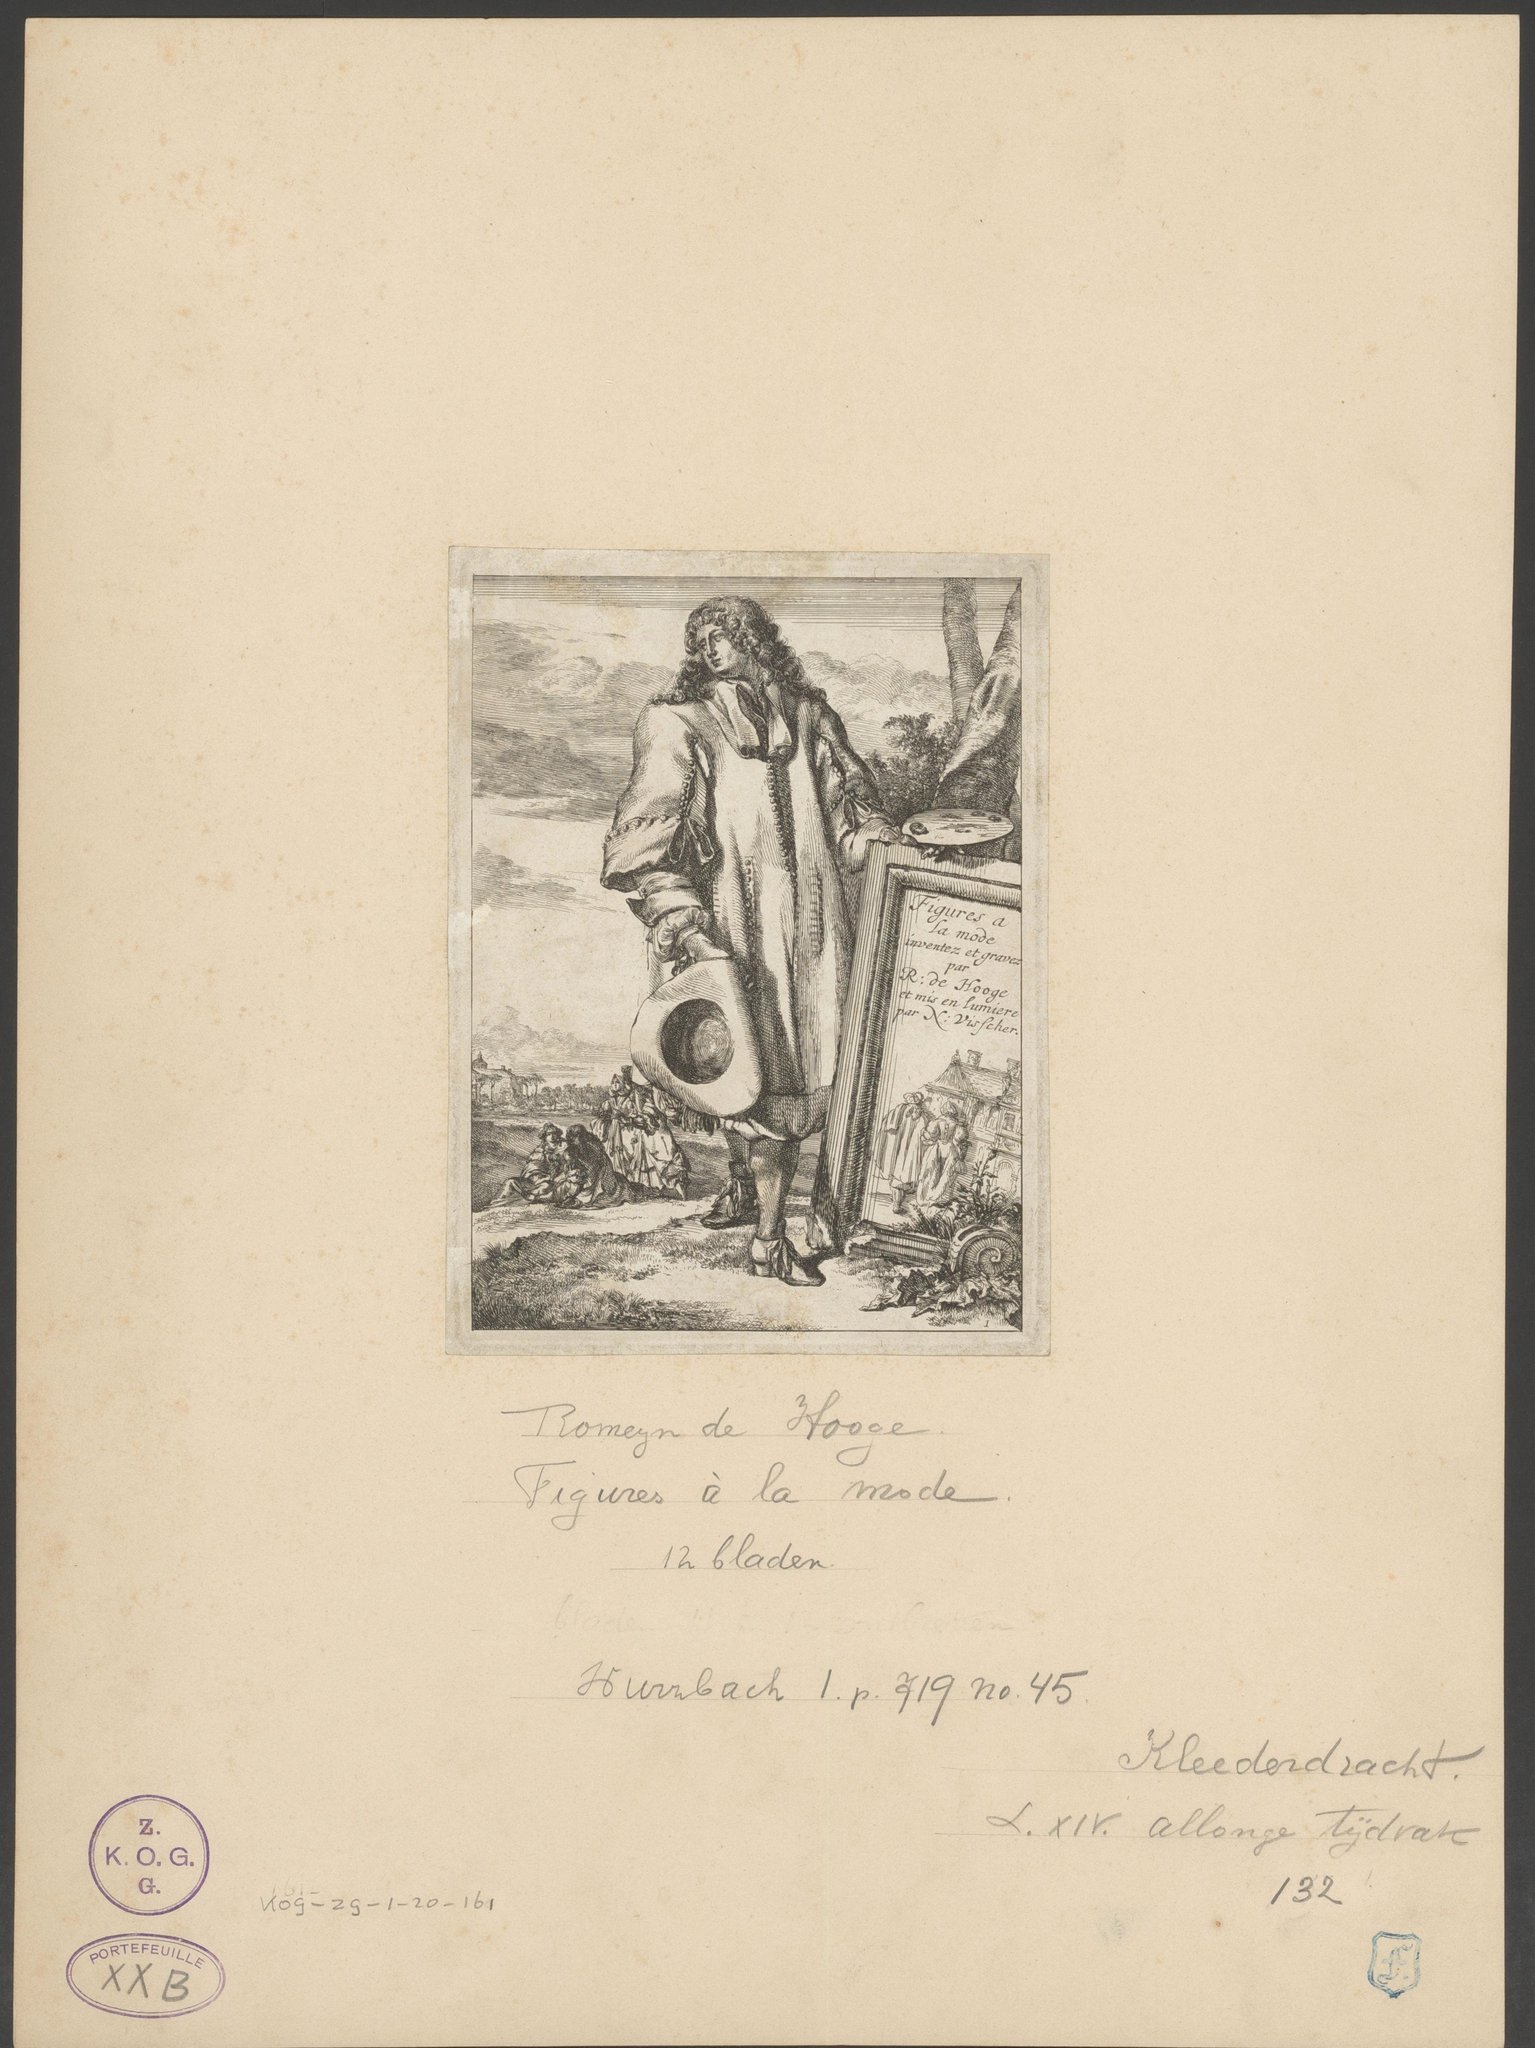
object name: titelprent, frontispice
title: Figures à la mode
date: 1662-1702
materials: paper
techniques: engraving, etching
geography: amsterdam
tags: coat, cape (+ men's clothes), head-gear: hat (+ men's clothes), styles of hairdress, fashion plates, tools, implements of painter, shoes, sandals (+ men's clothes), painter in non-work situation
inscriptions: collector's mark: Lugt 1641, stamp, collector's mark: Lugt 1641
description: Titelprent van 'Figures à la mode', een serie van twaalf kostuumprenten waarin de eigentijdse kleding van mannen en vrouwen wordt getoond. Een staande man in lange jas, hoed en schilderspalet in de hand, houdt een schilderij vast met daarop de titel van de serie en de namen van De Hooghe en Visscher. Op de achtergrond een groepje rustende figuren in een landschap. Rechtsonder genummerd: 1. Onderwerpsrubrieken binnen de Atlas Zeden en Gewoonten: Zeden en Gewoonten in Engeren Zin, De Kleeding, Kleederdrachten (tijdvakken), Lodewijk XIV (1650 – 1720). Het allonge tijdvak).